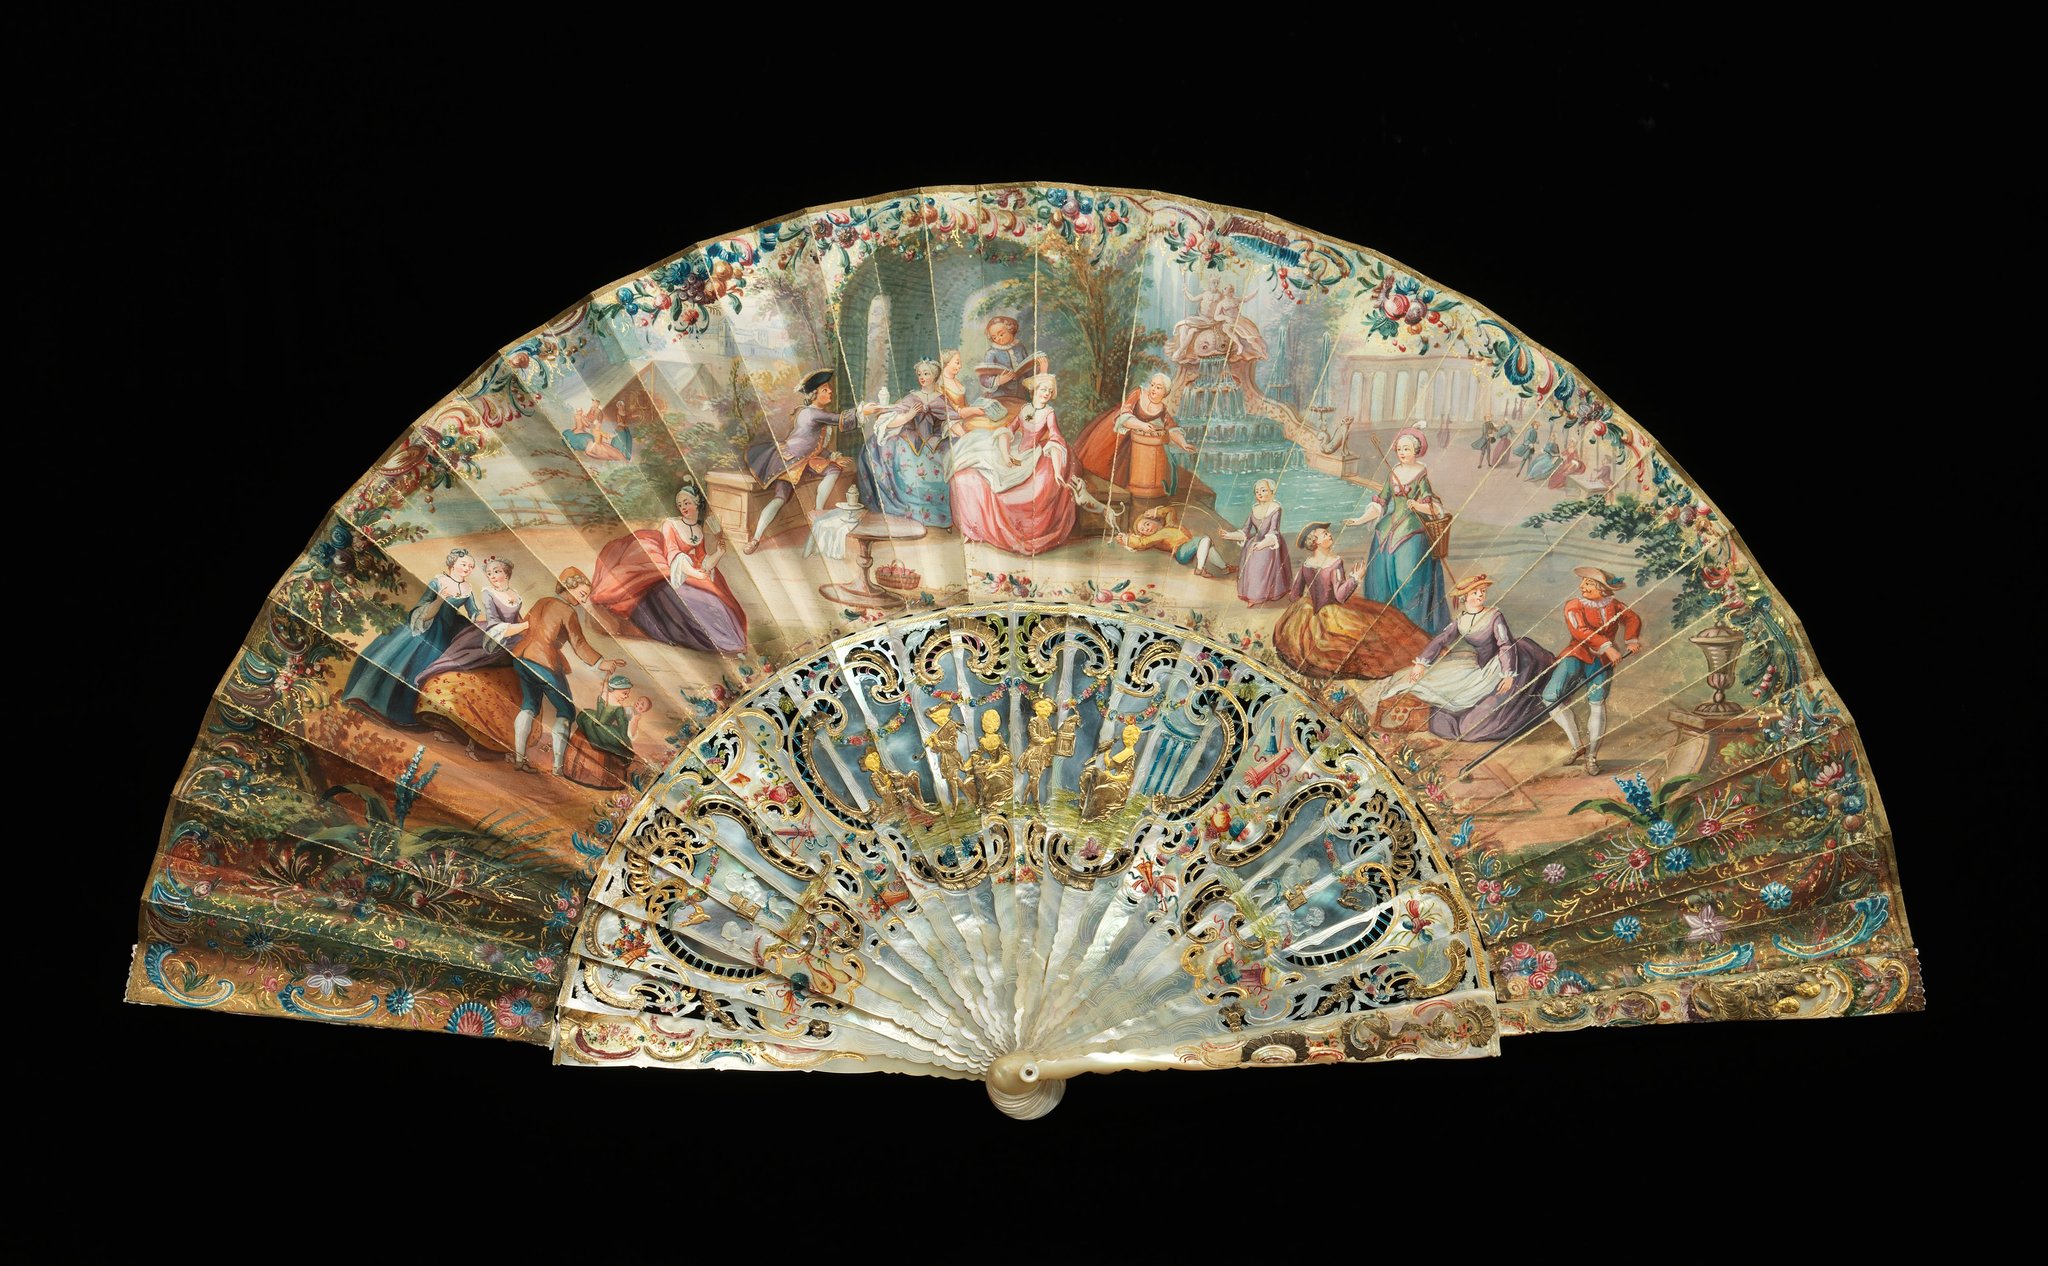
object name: fan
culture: french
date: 1870-1890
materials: gouache, metal, mother of pearl, paint, paper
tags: men,women